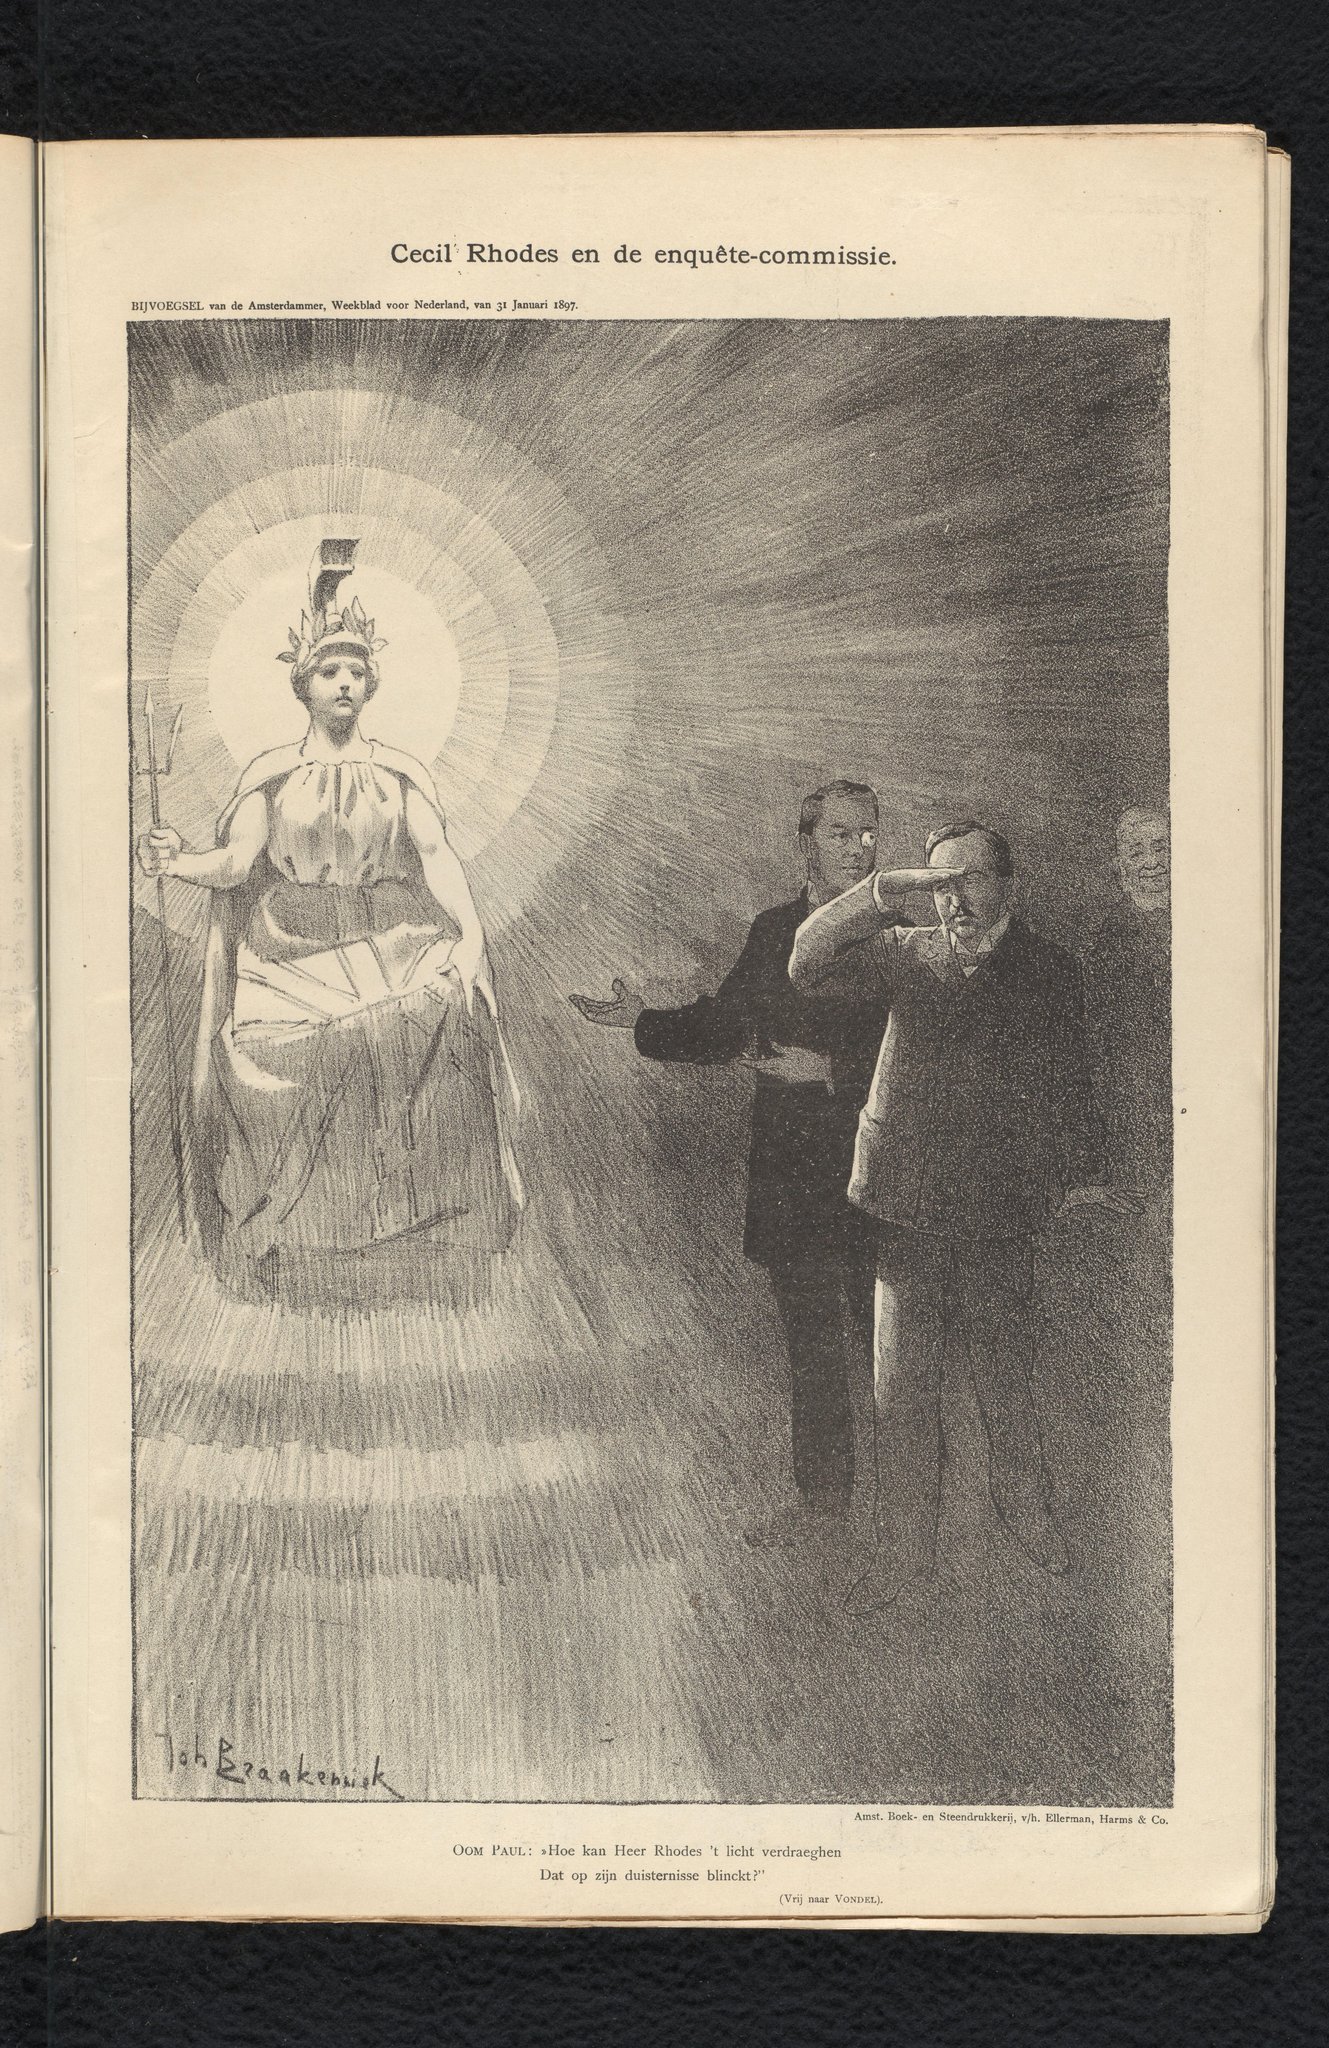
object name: cartoon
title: Cecil Rhodes en de enquête-commissie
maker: johan braakensiek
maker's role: draughtsman, print maker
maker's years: 1858-1940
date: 1897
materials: paper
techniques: lithograph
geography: amsterdam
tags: personifications of countries, nations, states, districts, etc., political caricatures and satires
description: Cecil Rhodes verblind door het felle licht van de stralende Brittannica. Met Chamberlain en een lachende Paul Kruger.